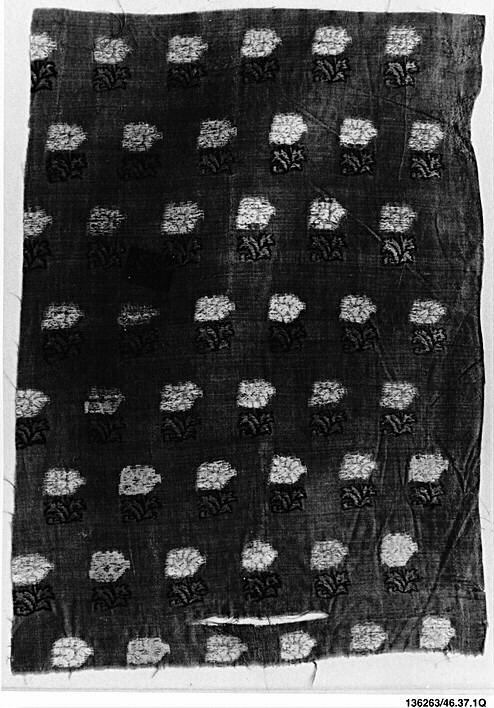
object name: textile fragment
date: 1701-1800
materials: cotton, silk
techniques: brocade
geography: india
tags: flowers